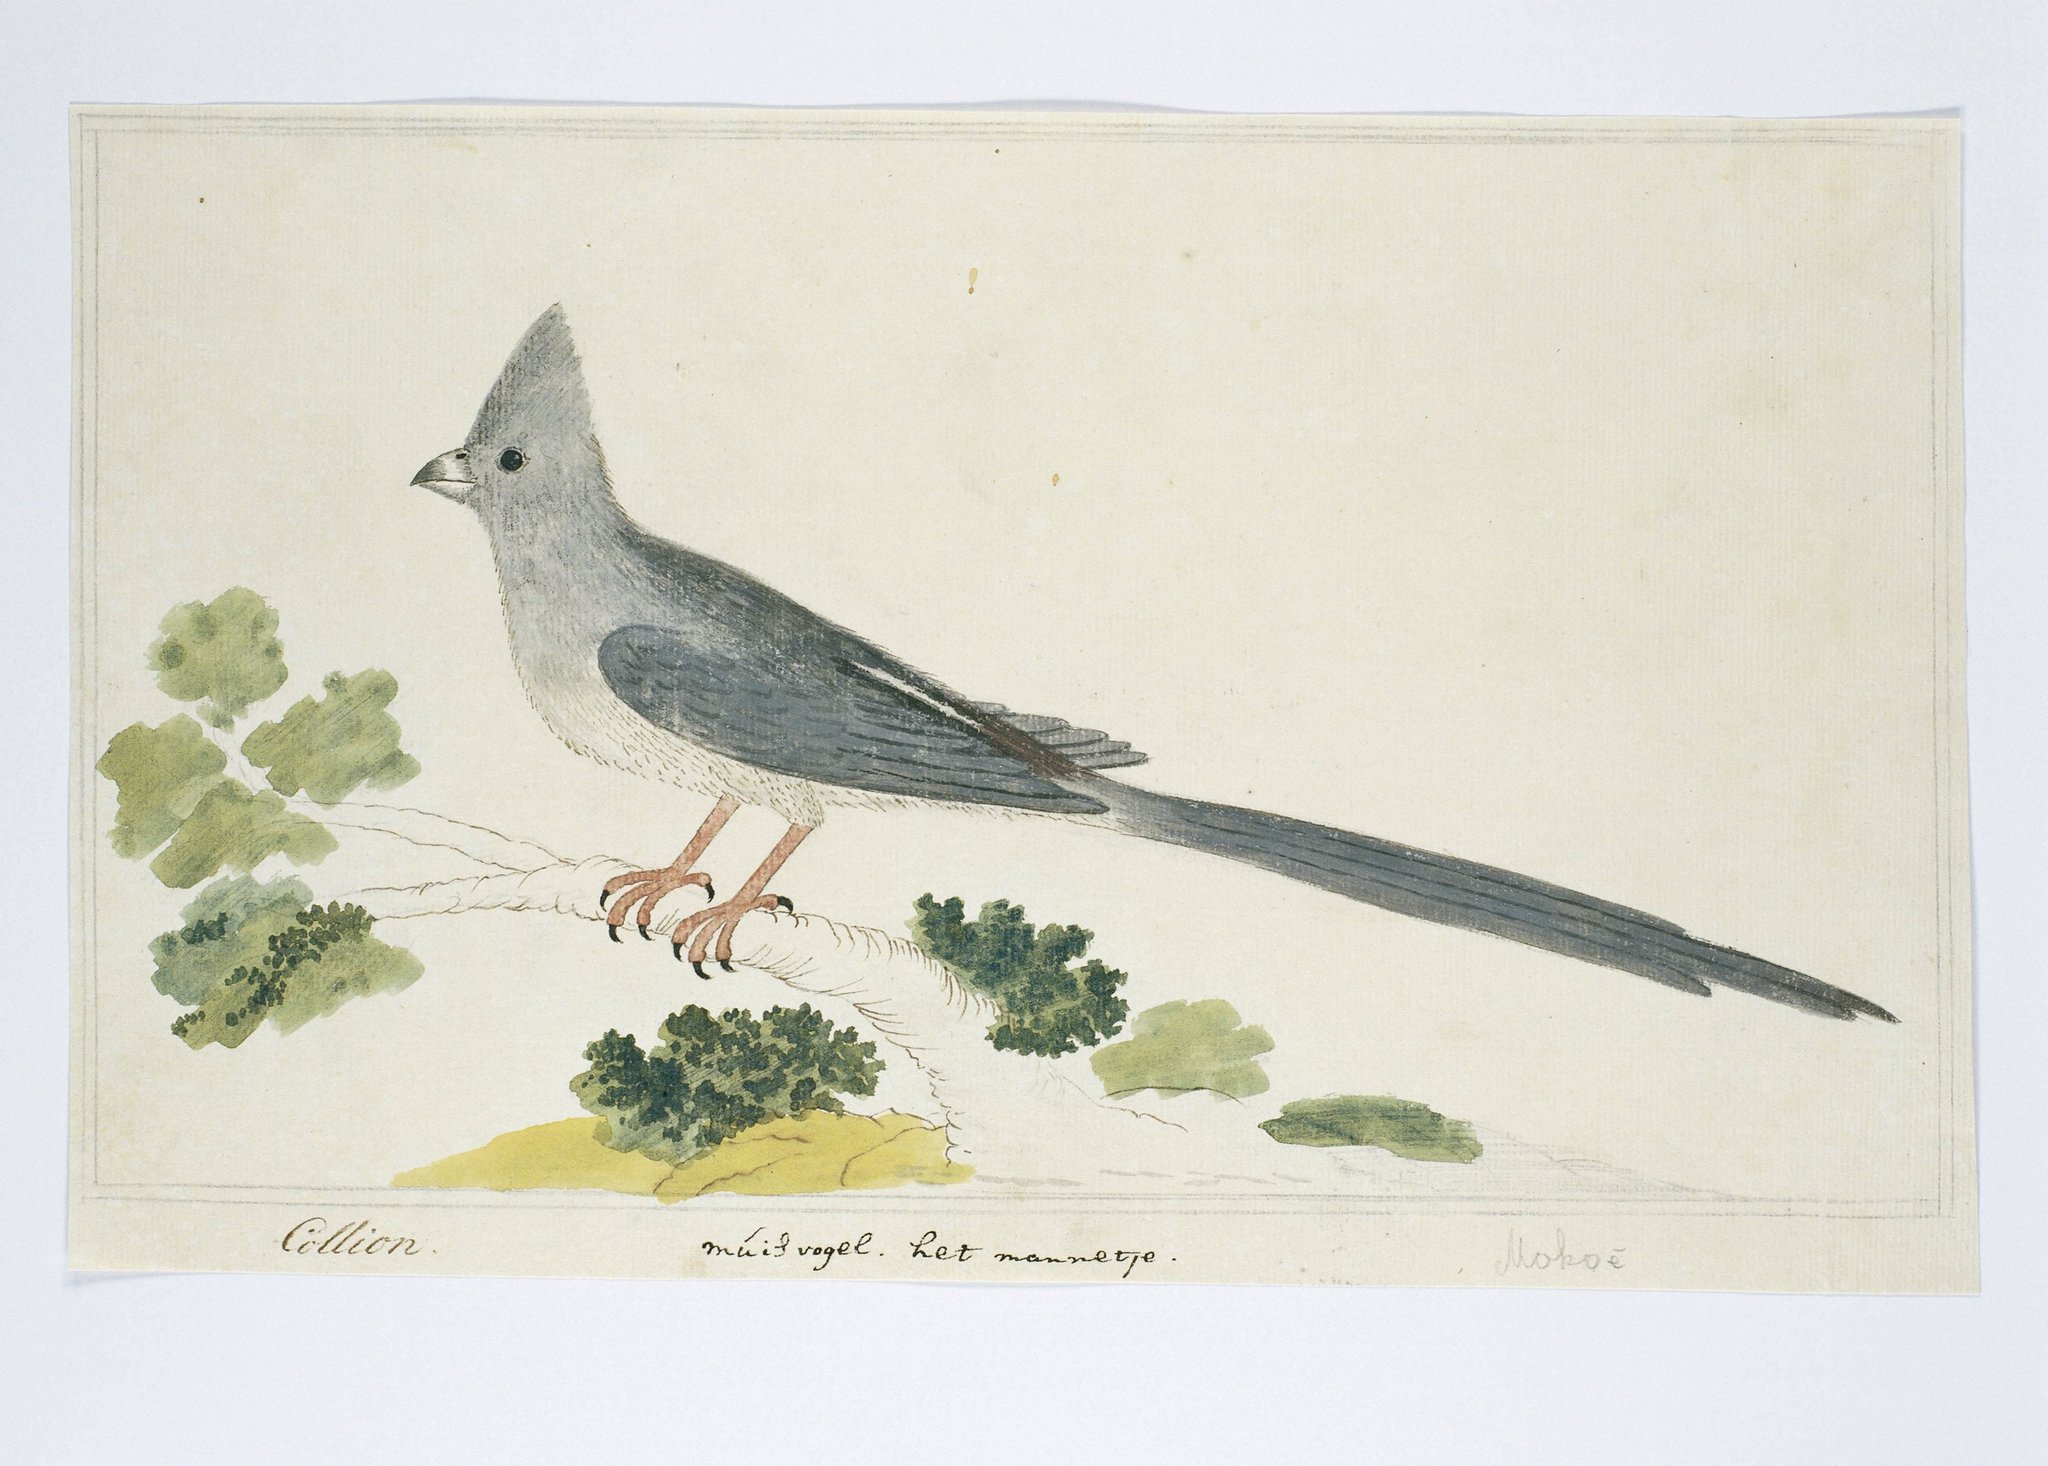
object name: drawing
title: Colius colius ? (White-backed mousebird)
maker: robert jacob gordon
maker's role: draughtsman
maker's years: 1743-1795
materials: chalk, ink, paper, pencil, watercolor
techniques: brush, pen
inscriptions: annotation: ‘Collion. múisvogel. het mannetje. Mokoe (in potlood)’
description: White-backed mousebird (Eng.). Franse benaming geschreven door Levaillant.